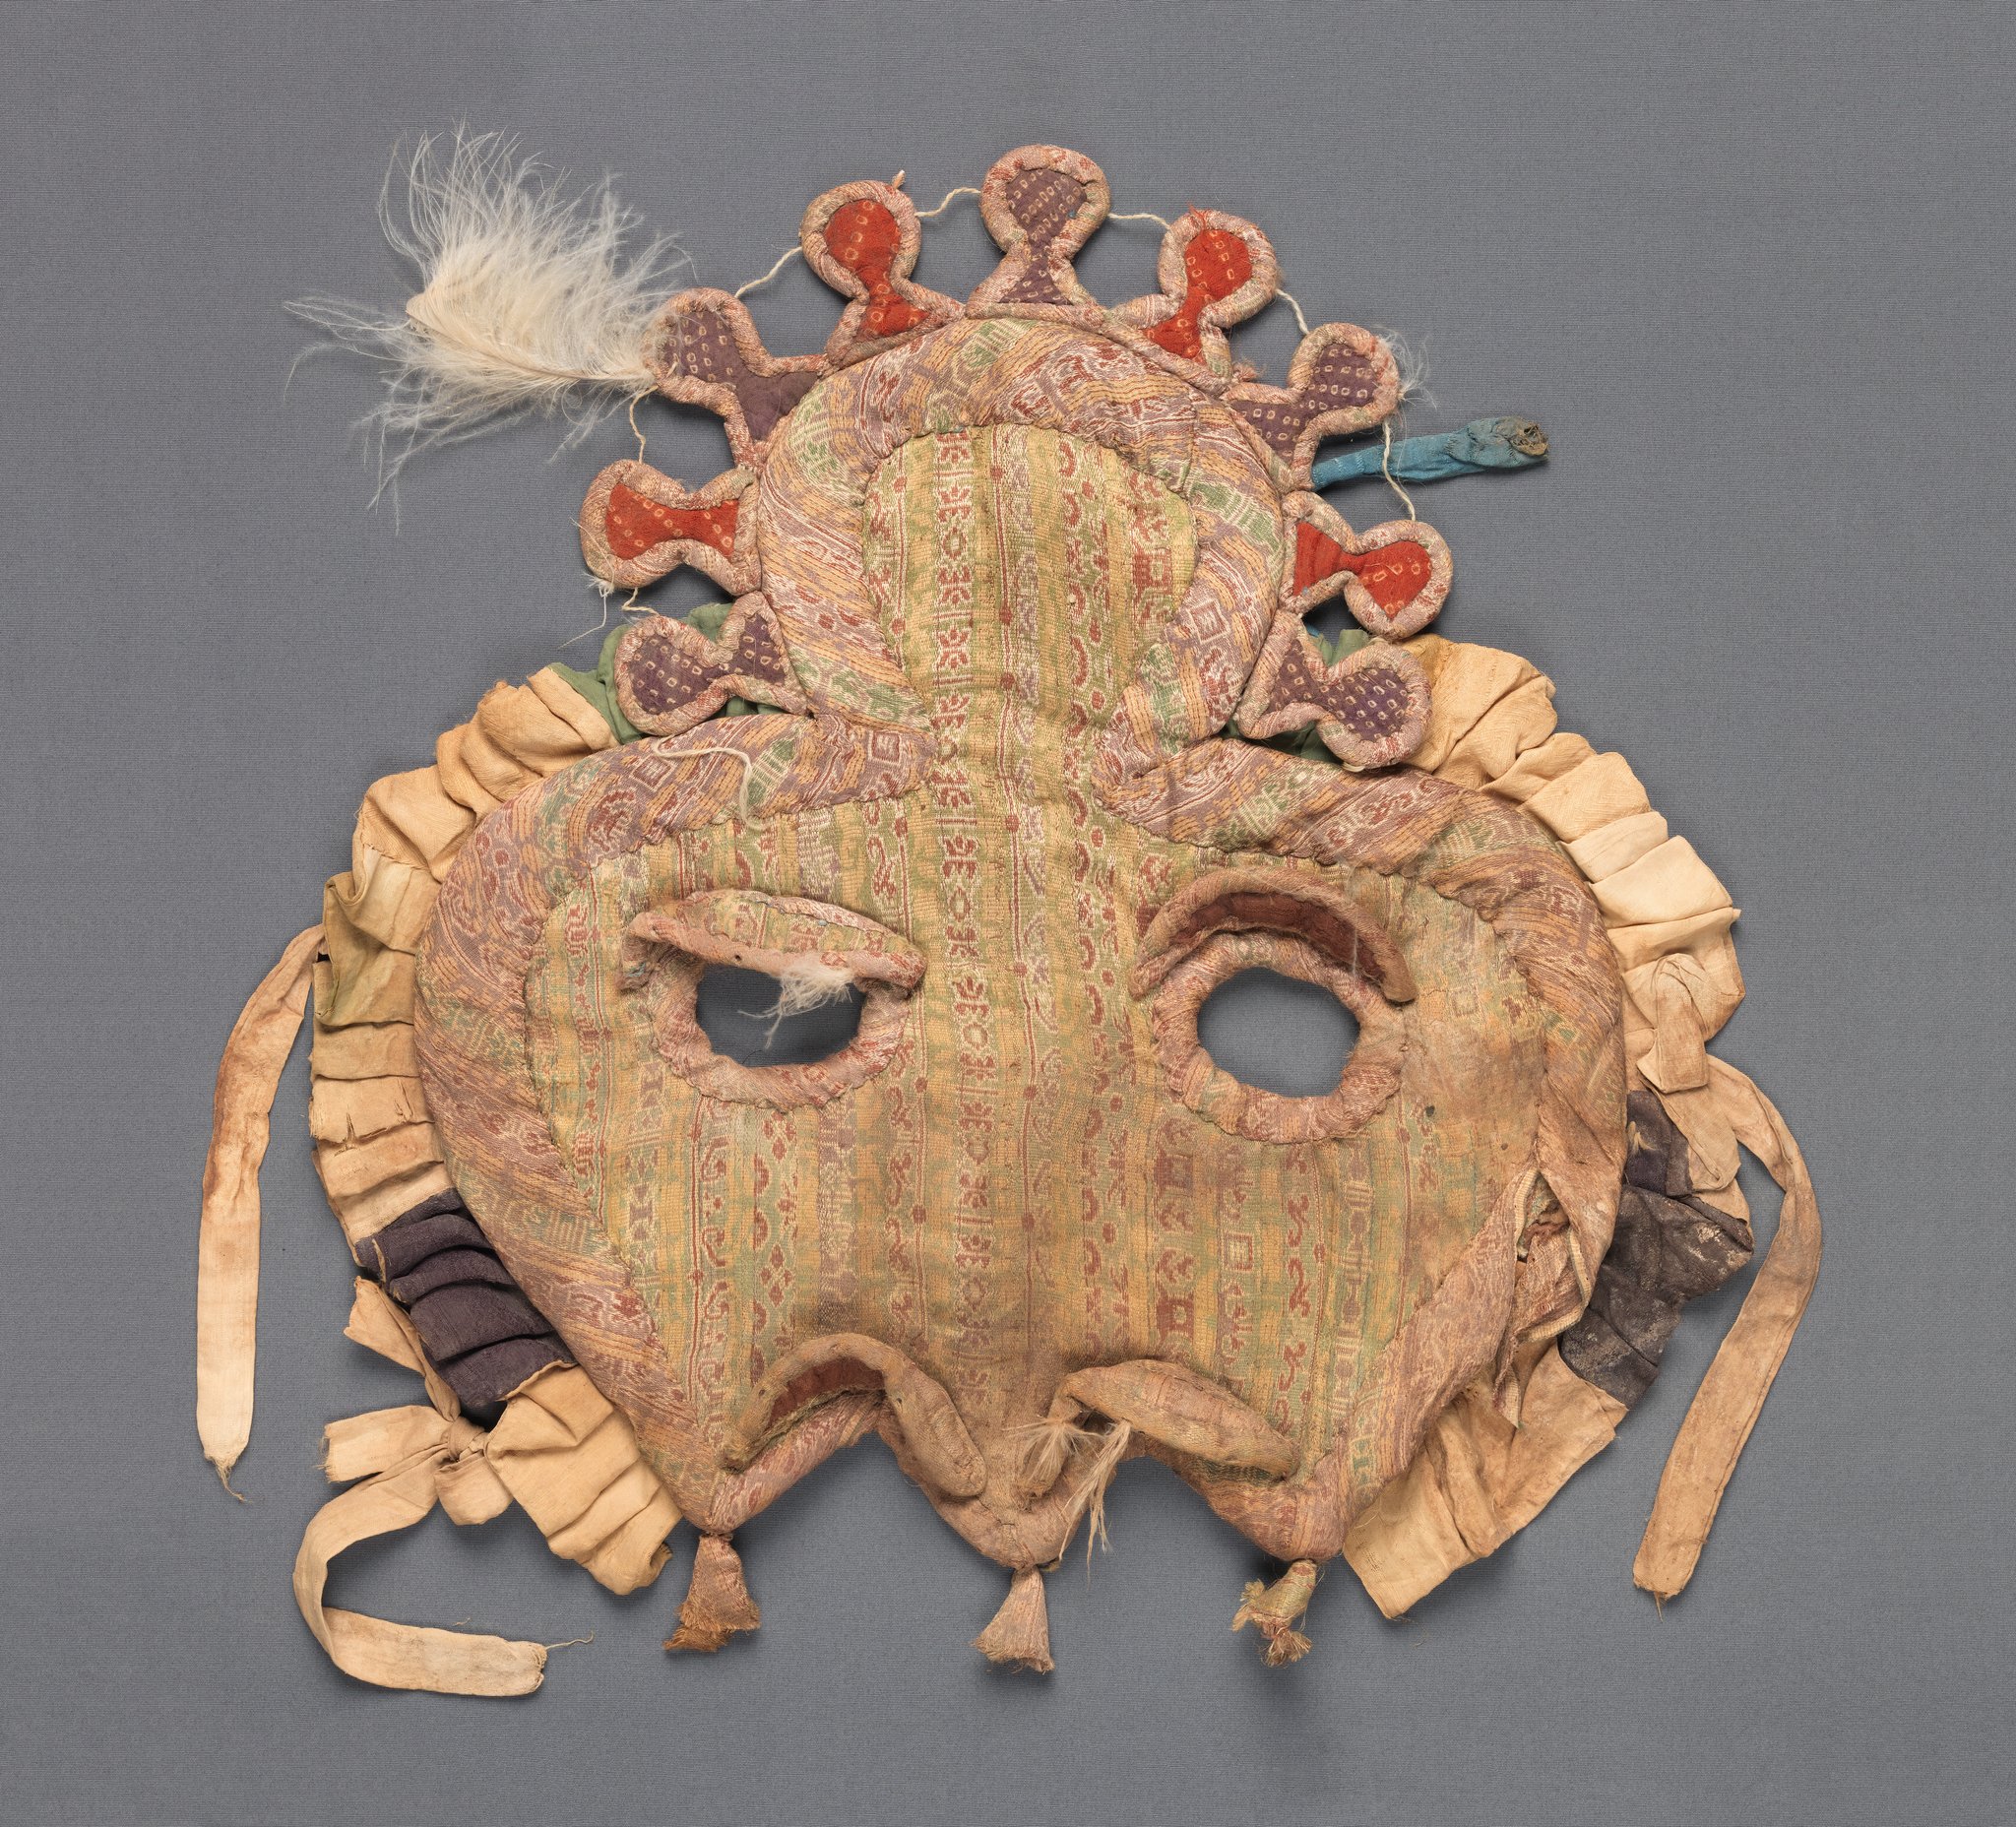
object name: shaffron horse's head defense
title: Shaffron (Horse's Head Defense)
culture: central asian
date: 401-700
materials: feather, fiber, textile